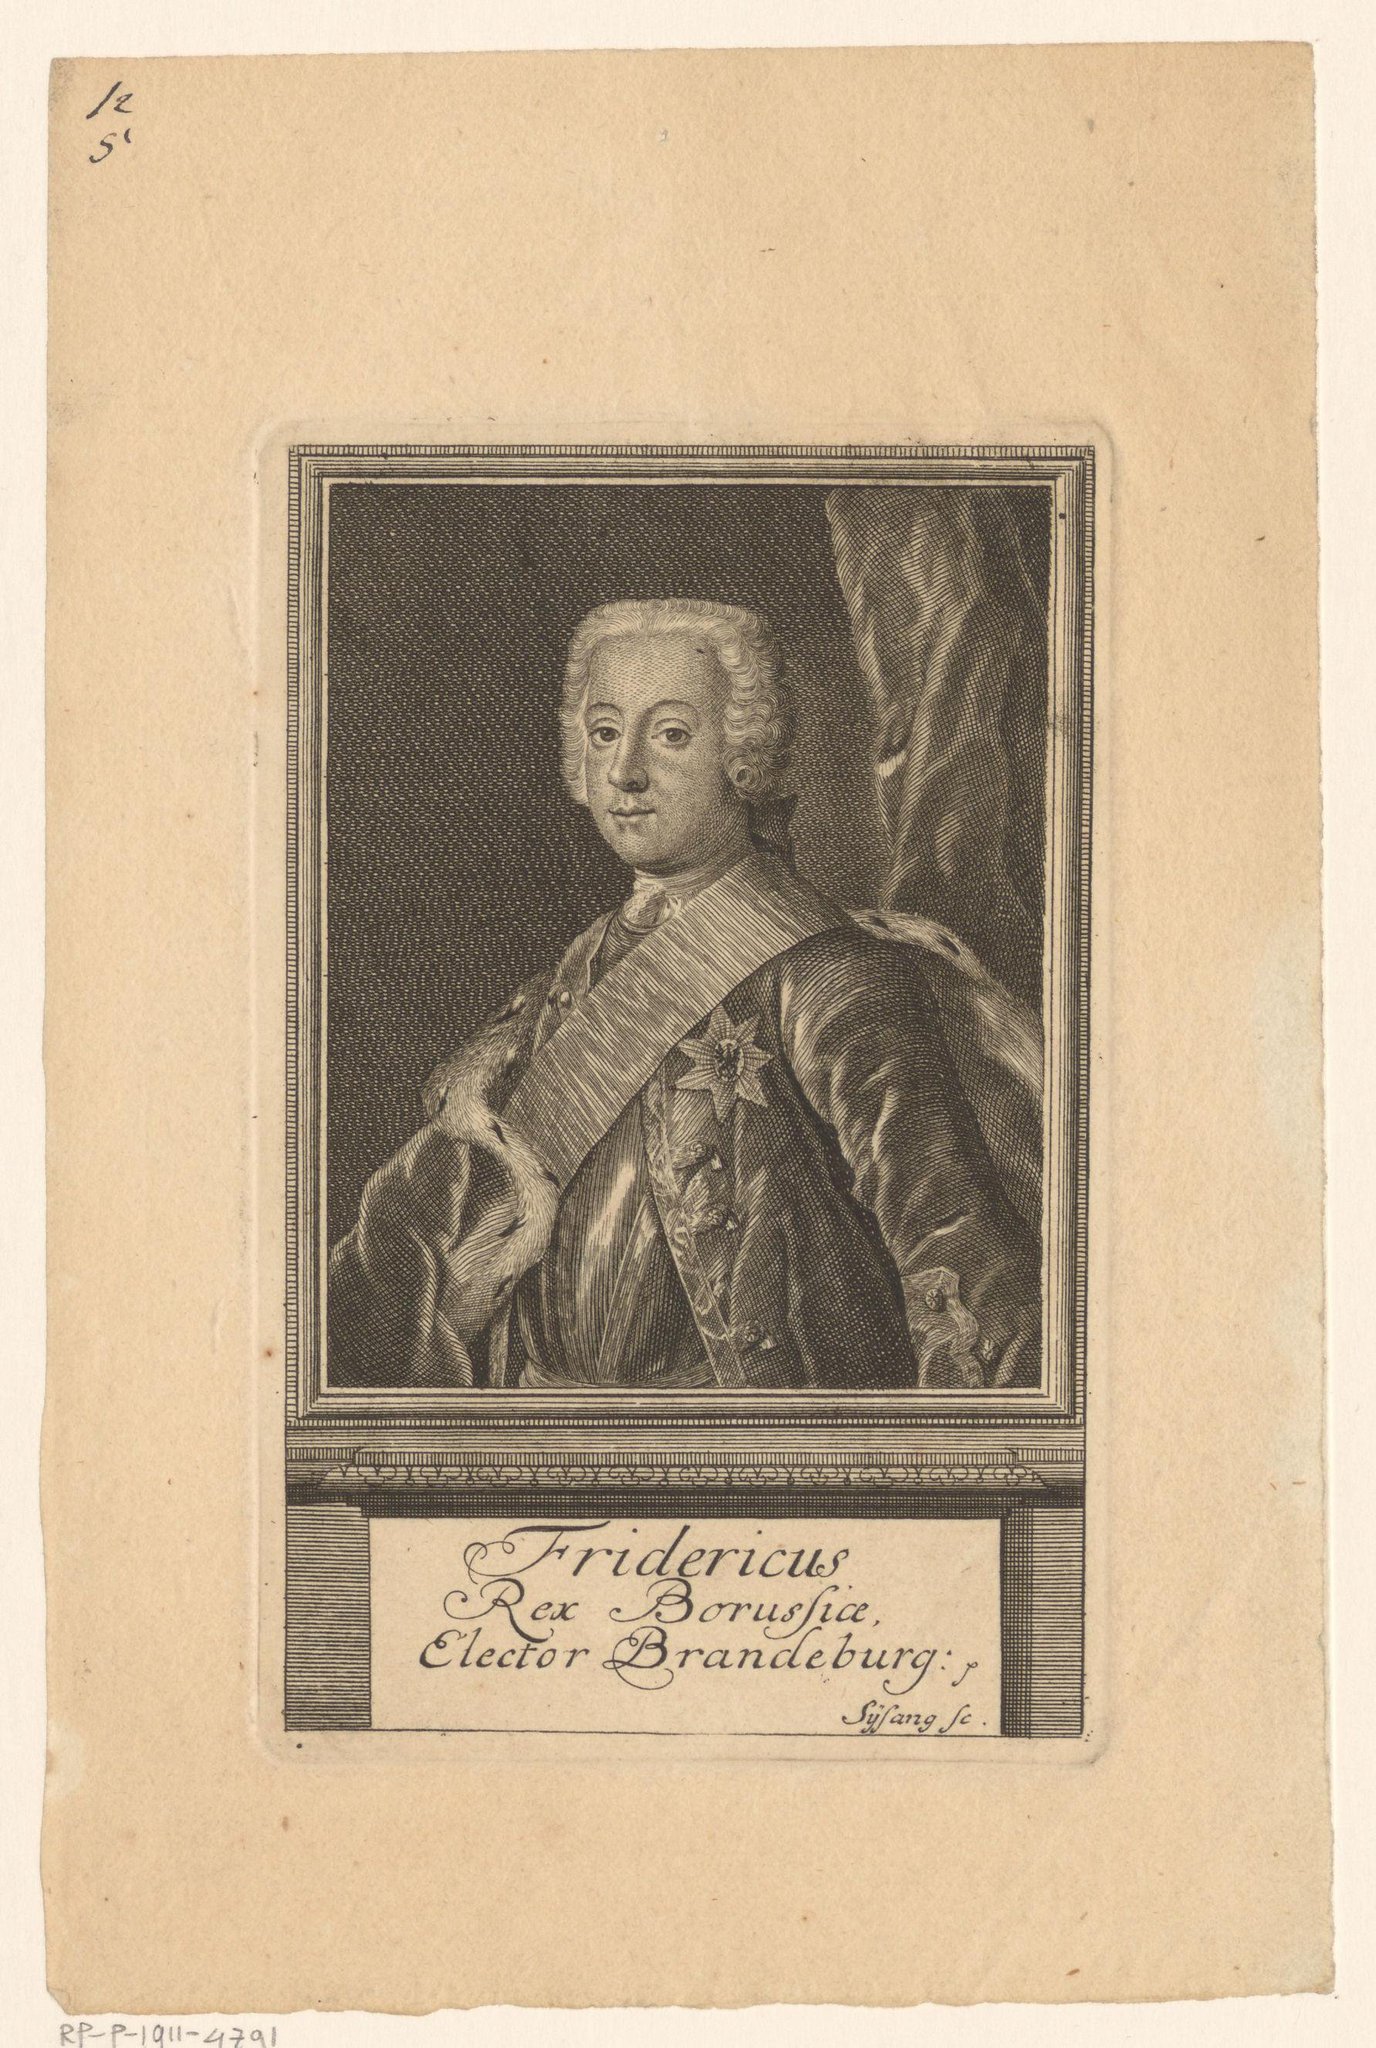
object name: print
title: Portret van Frederik I, koning van Pruisen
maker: johann christoph sysang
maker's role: print maker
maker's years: 1703-1757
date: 1713-1757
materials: paper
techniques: engraving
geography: germany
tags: frederik i koning van pruisen, historical persons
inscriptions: number: ‘12/ 5’, collector's mark: Lugt 2228